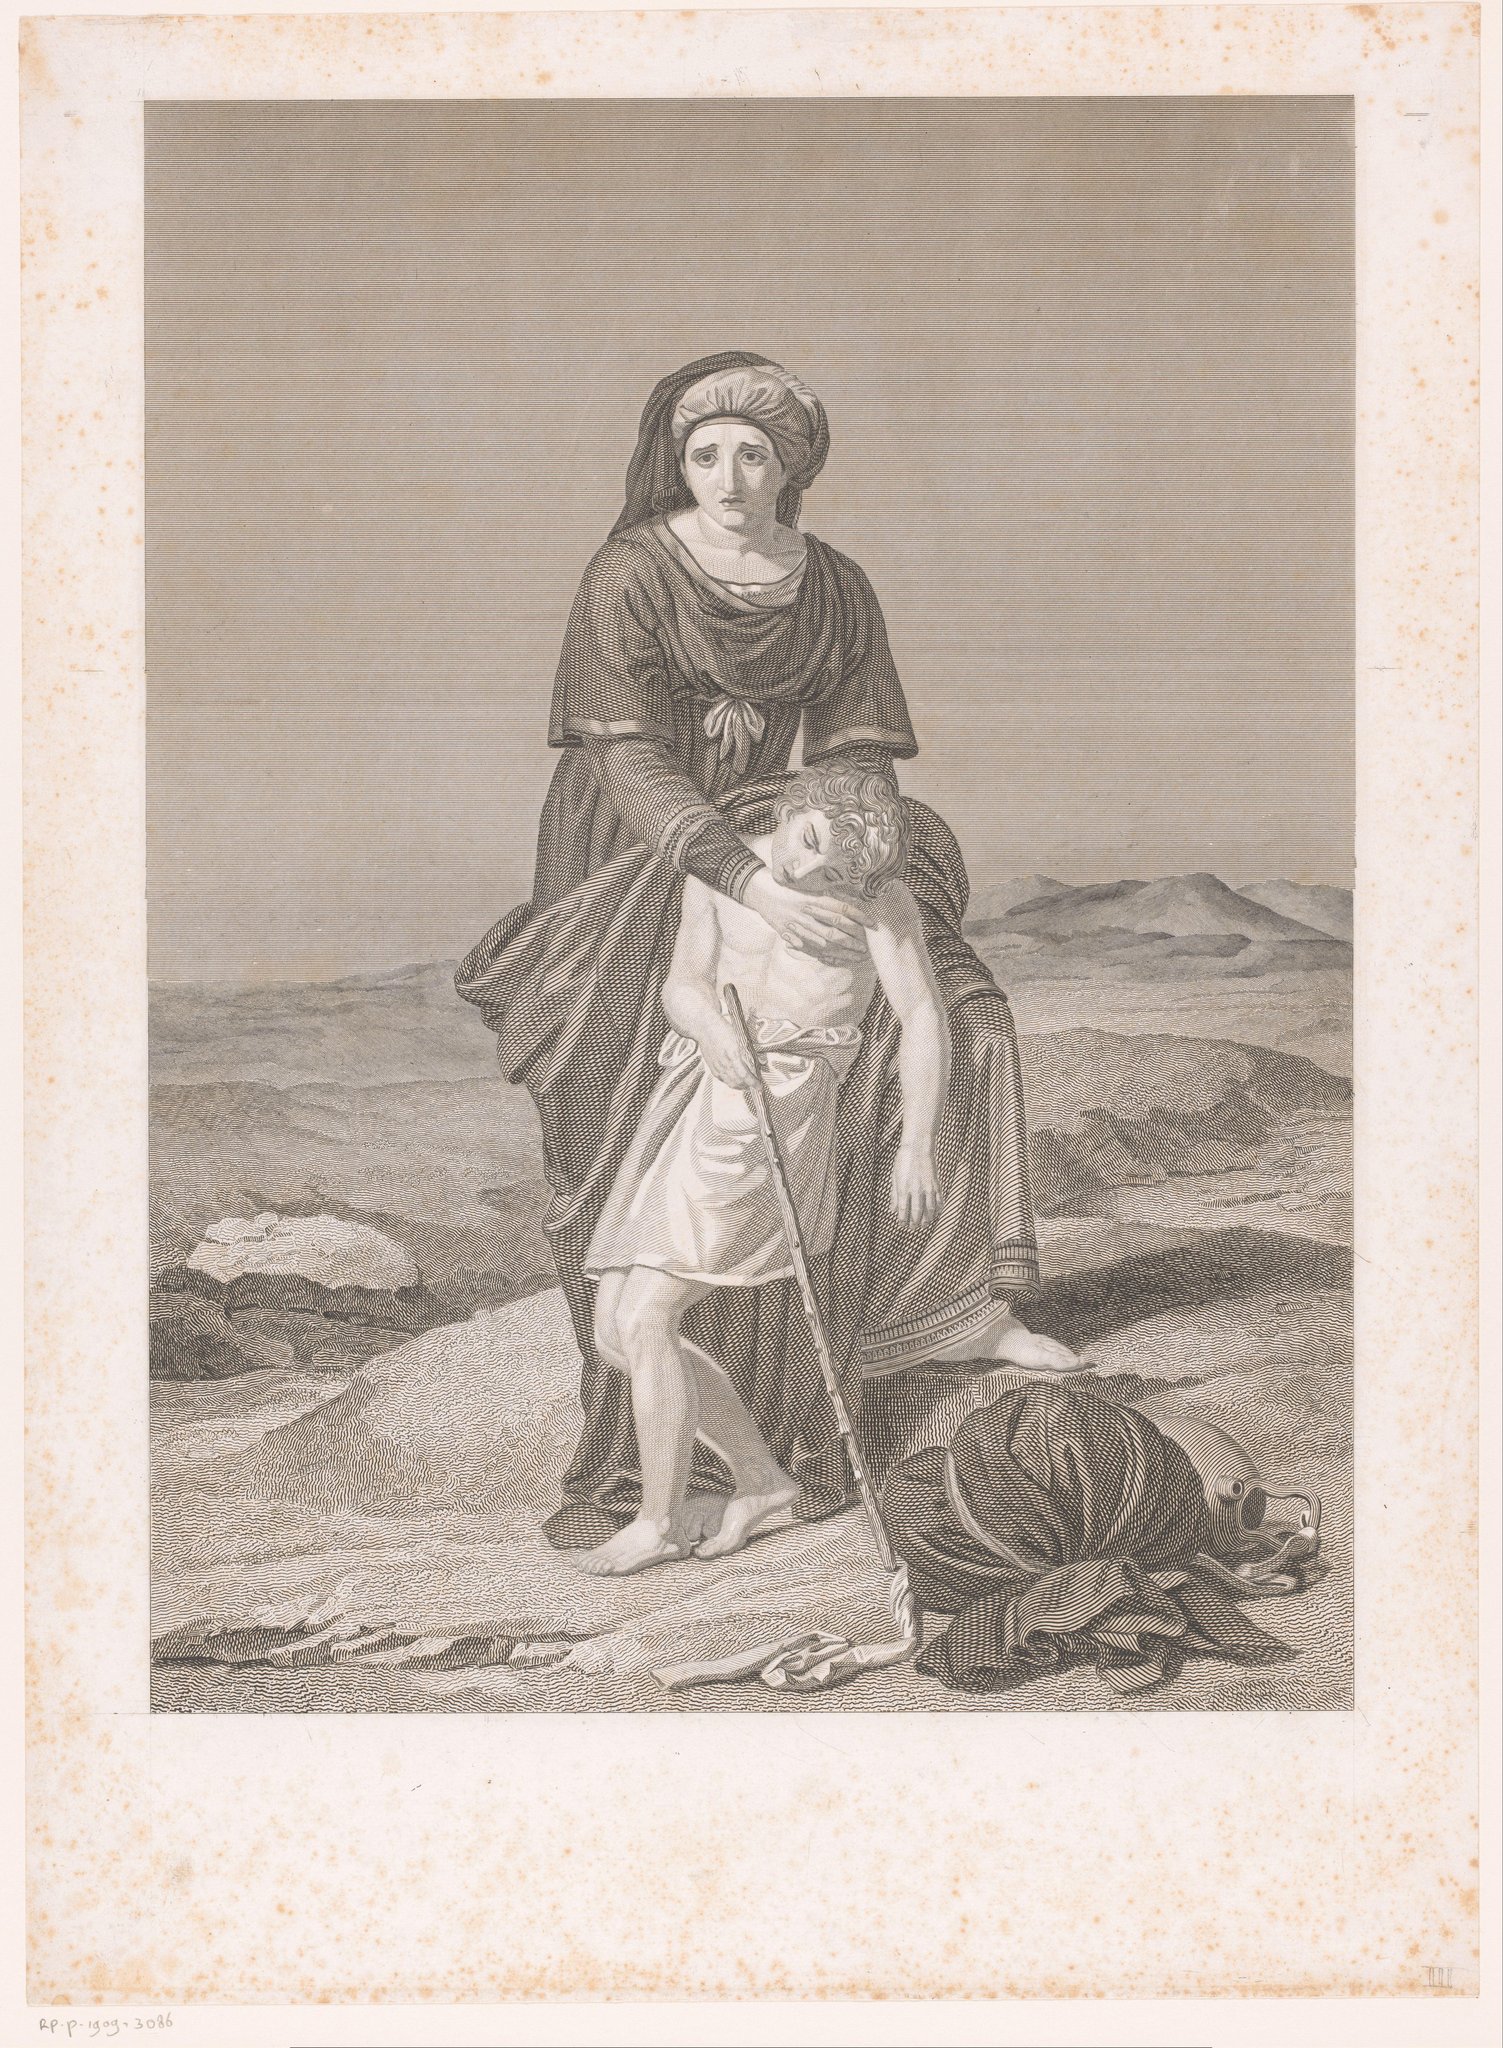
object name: print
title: Hagar en Ishmael in de woestijn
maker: erin corr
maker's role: draughtsman, print maker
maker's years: 1805-1862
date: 1815-1862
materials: paper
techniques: engraving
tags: hagar and ishmael in the wilderness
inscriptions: collector's mark: Lugt 2228